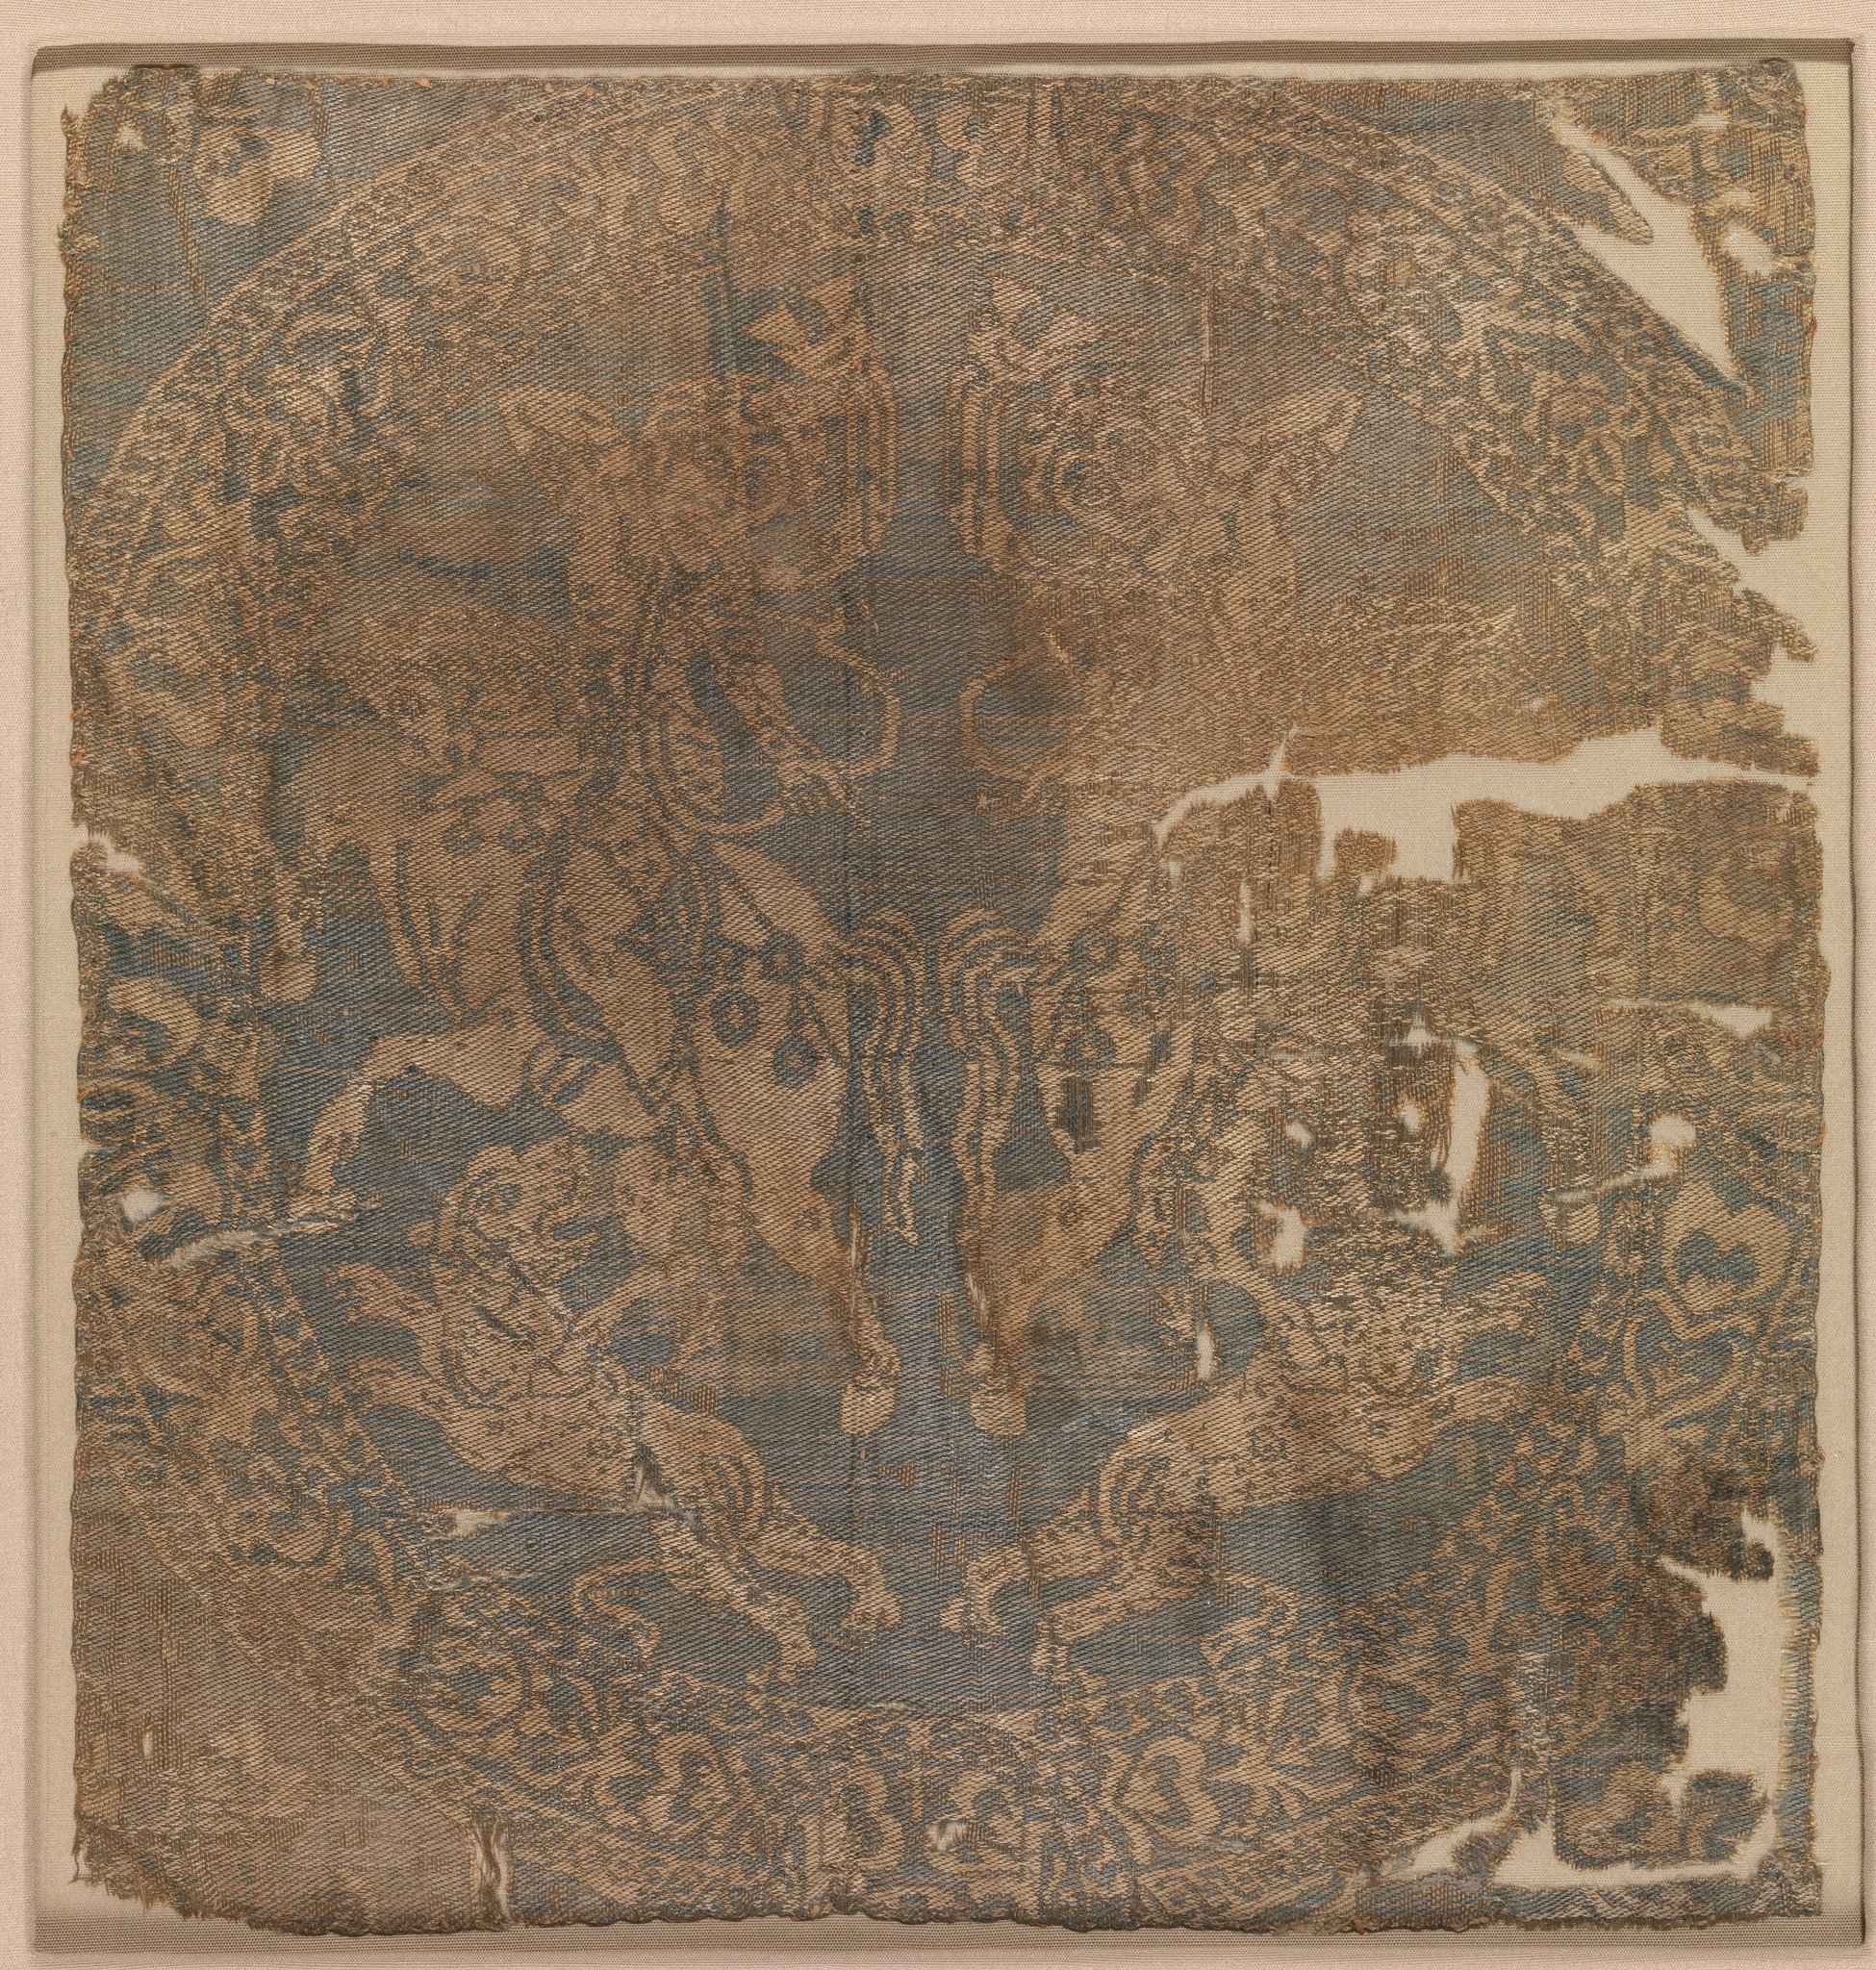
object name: roundel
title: Roundel with Amazons and a Cross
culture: byzantine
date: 601-900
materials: silk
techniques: weave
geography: egypt or syria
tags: bow and arrow,amazons,horses,lions